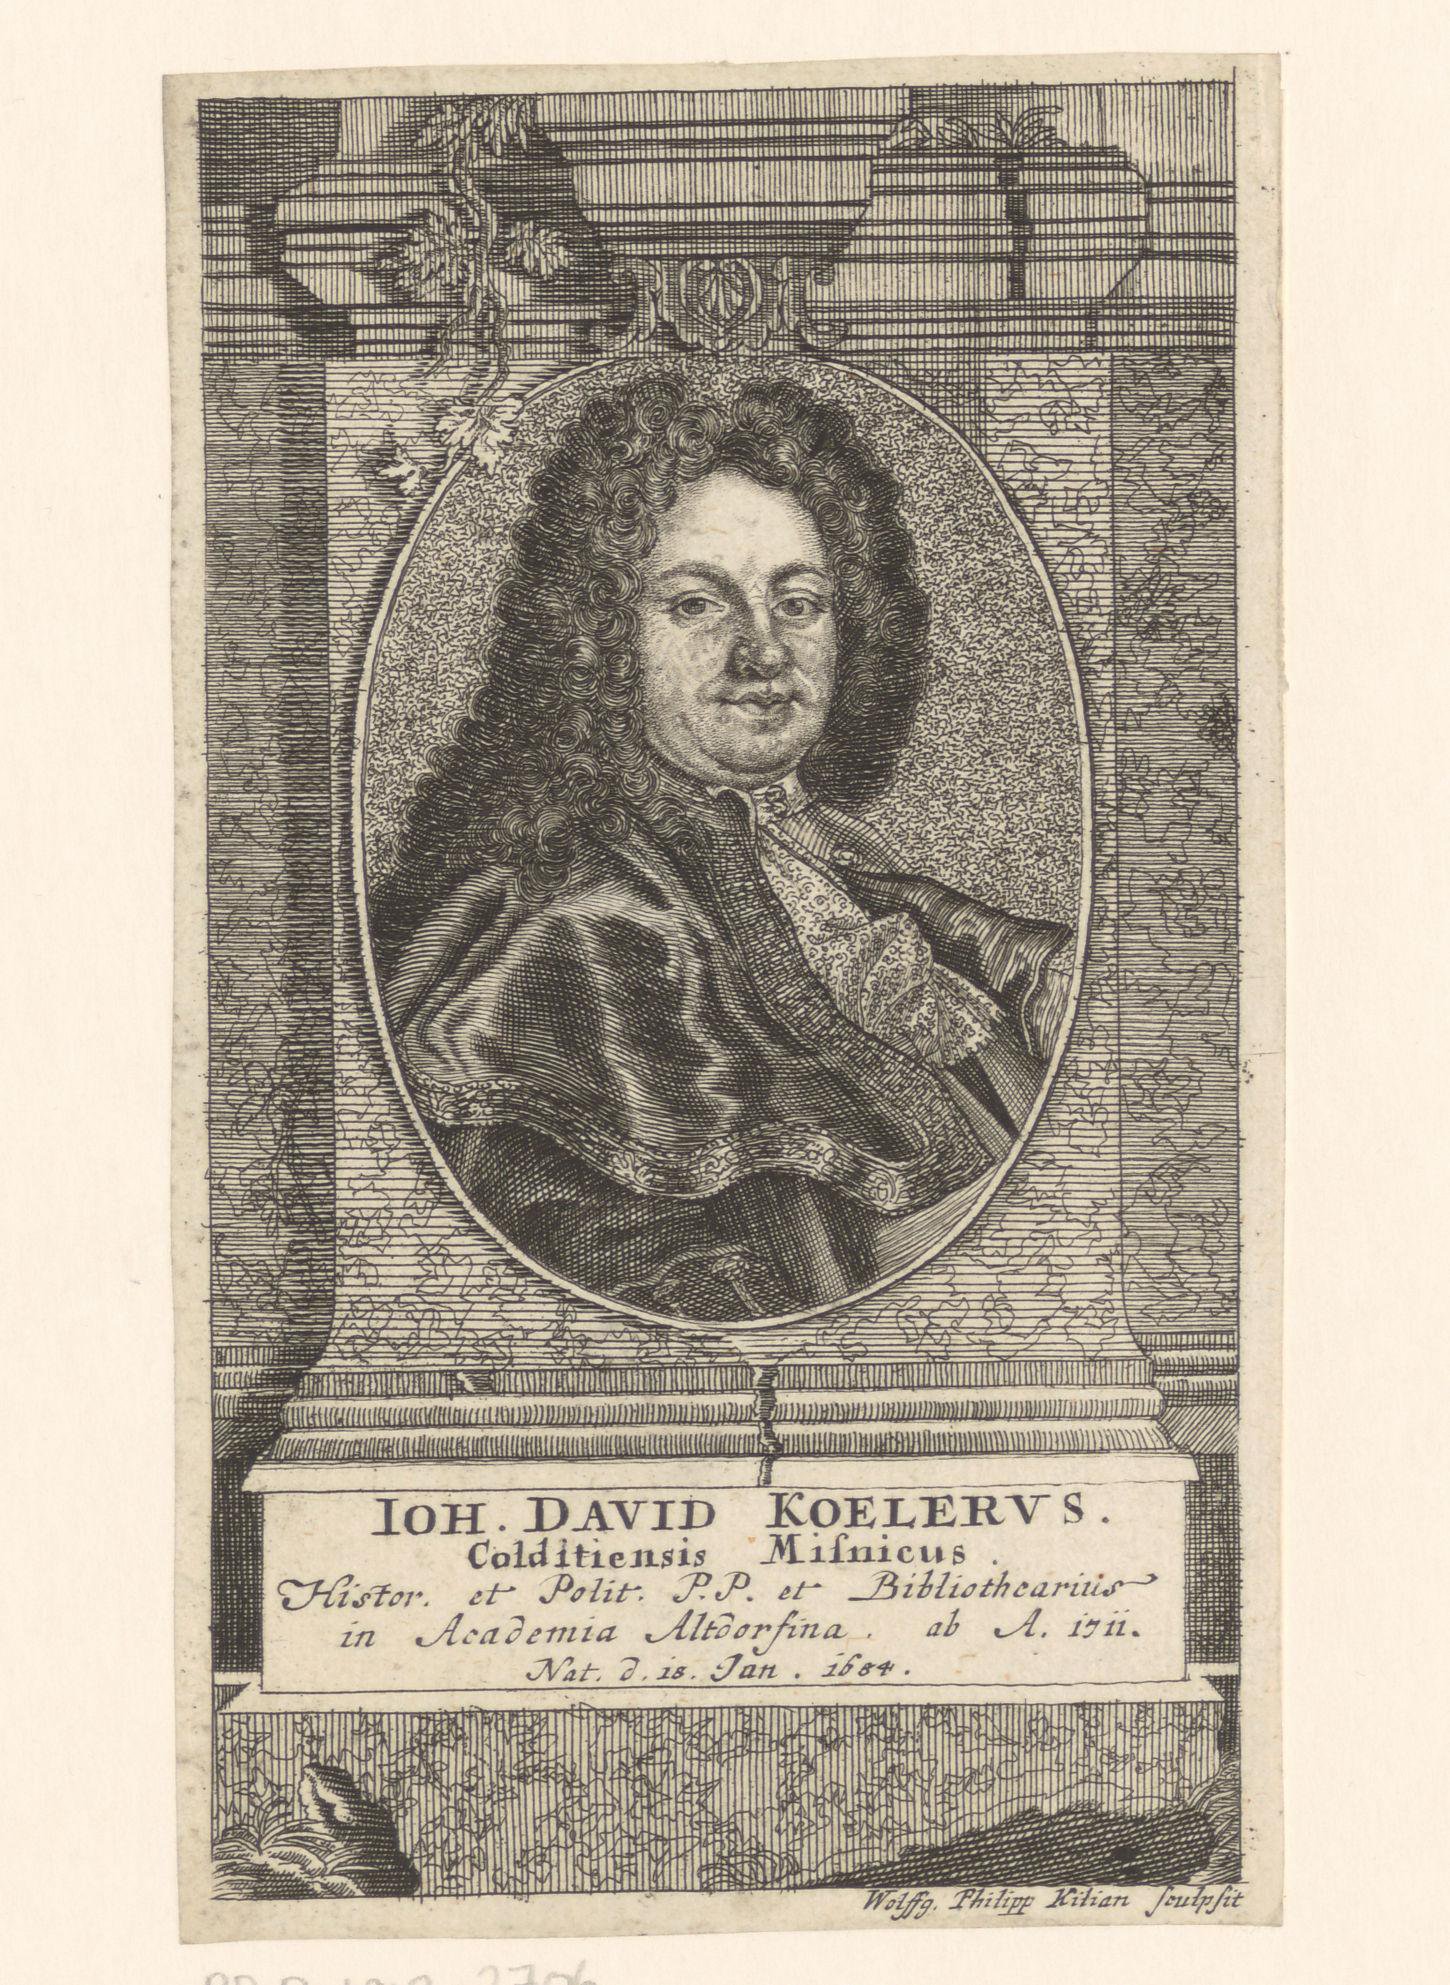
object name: print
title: Portret van Johann David Köhler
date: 1692-1732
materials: paper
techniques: engraving, etching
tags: history and archaeology (+ portrait of scholar, scientist), historical persons, politician, e.g. party leader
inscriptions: collector's mark: Lugt 2228